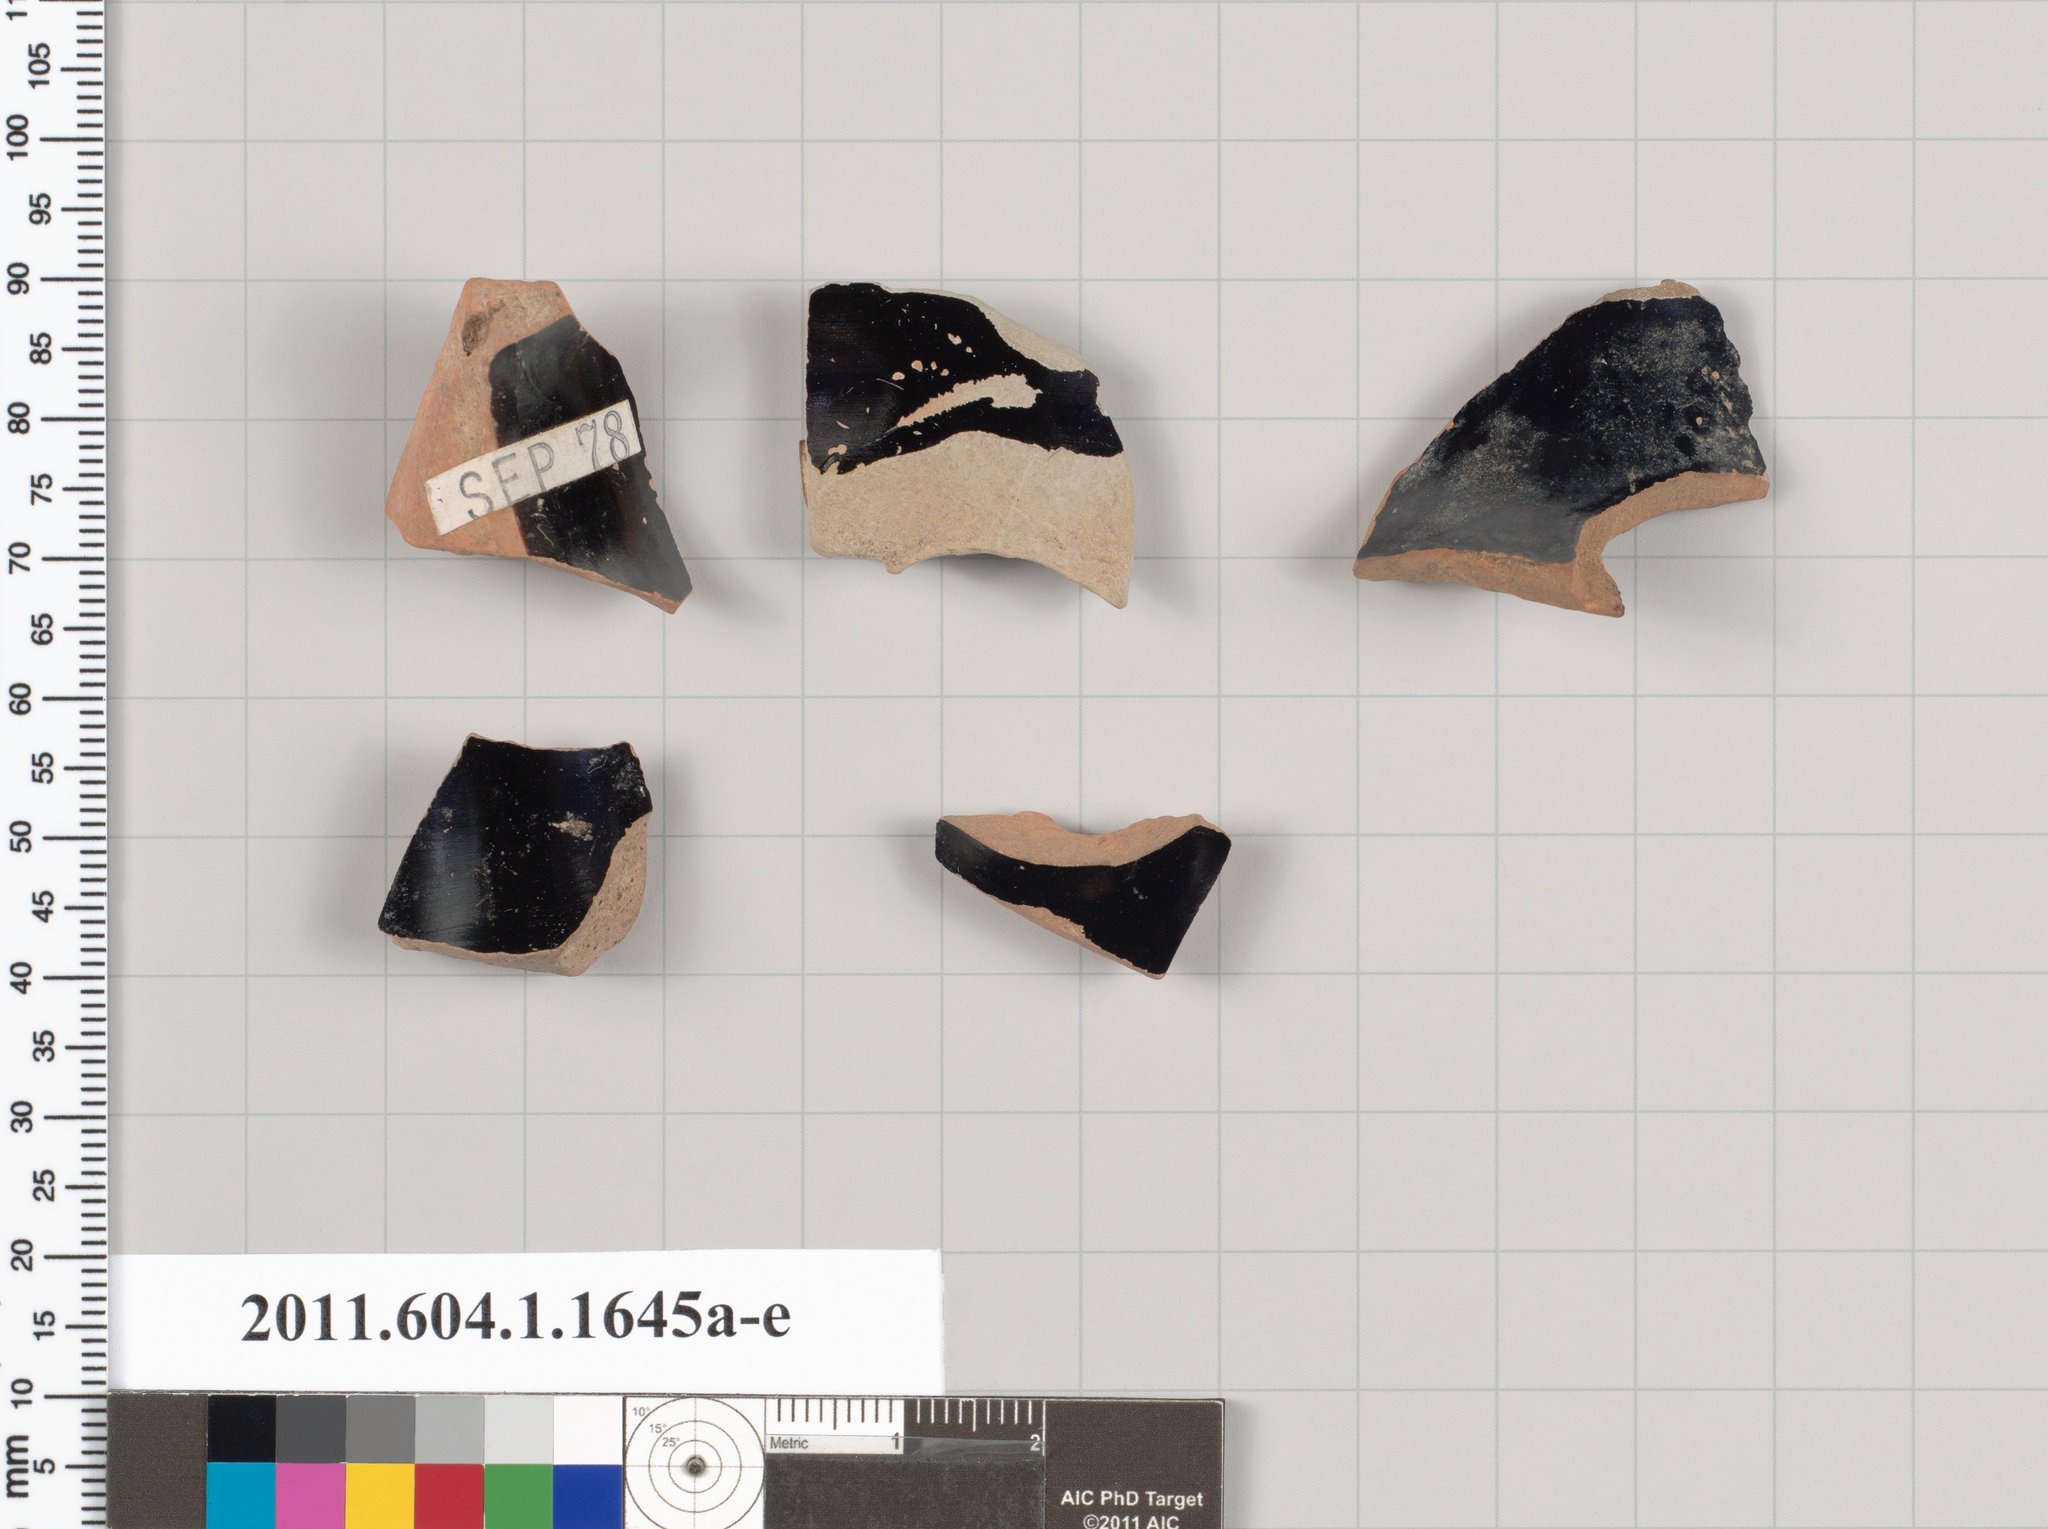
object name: kylix fragment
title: Terracotta fragments of kylikes (drinking cups)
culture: greek, attic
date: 500-401 BCE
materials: terracotta